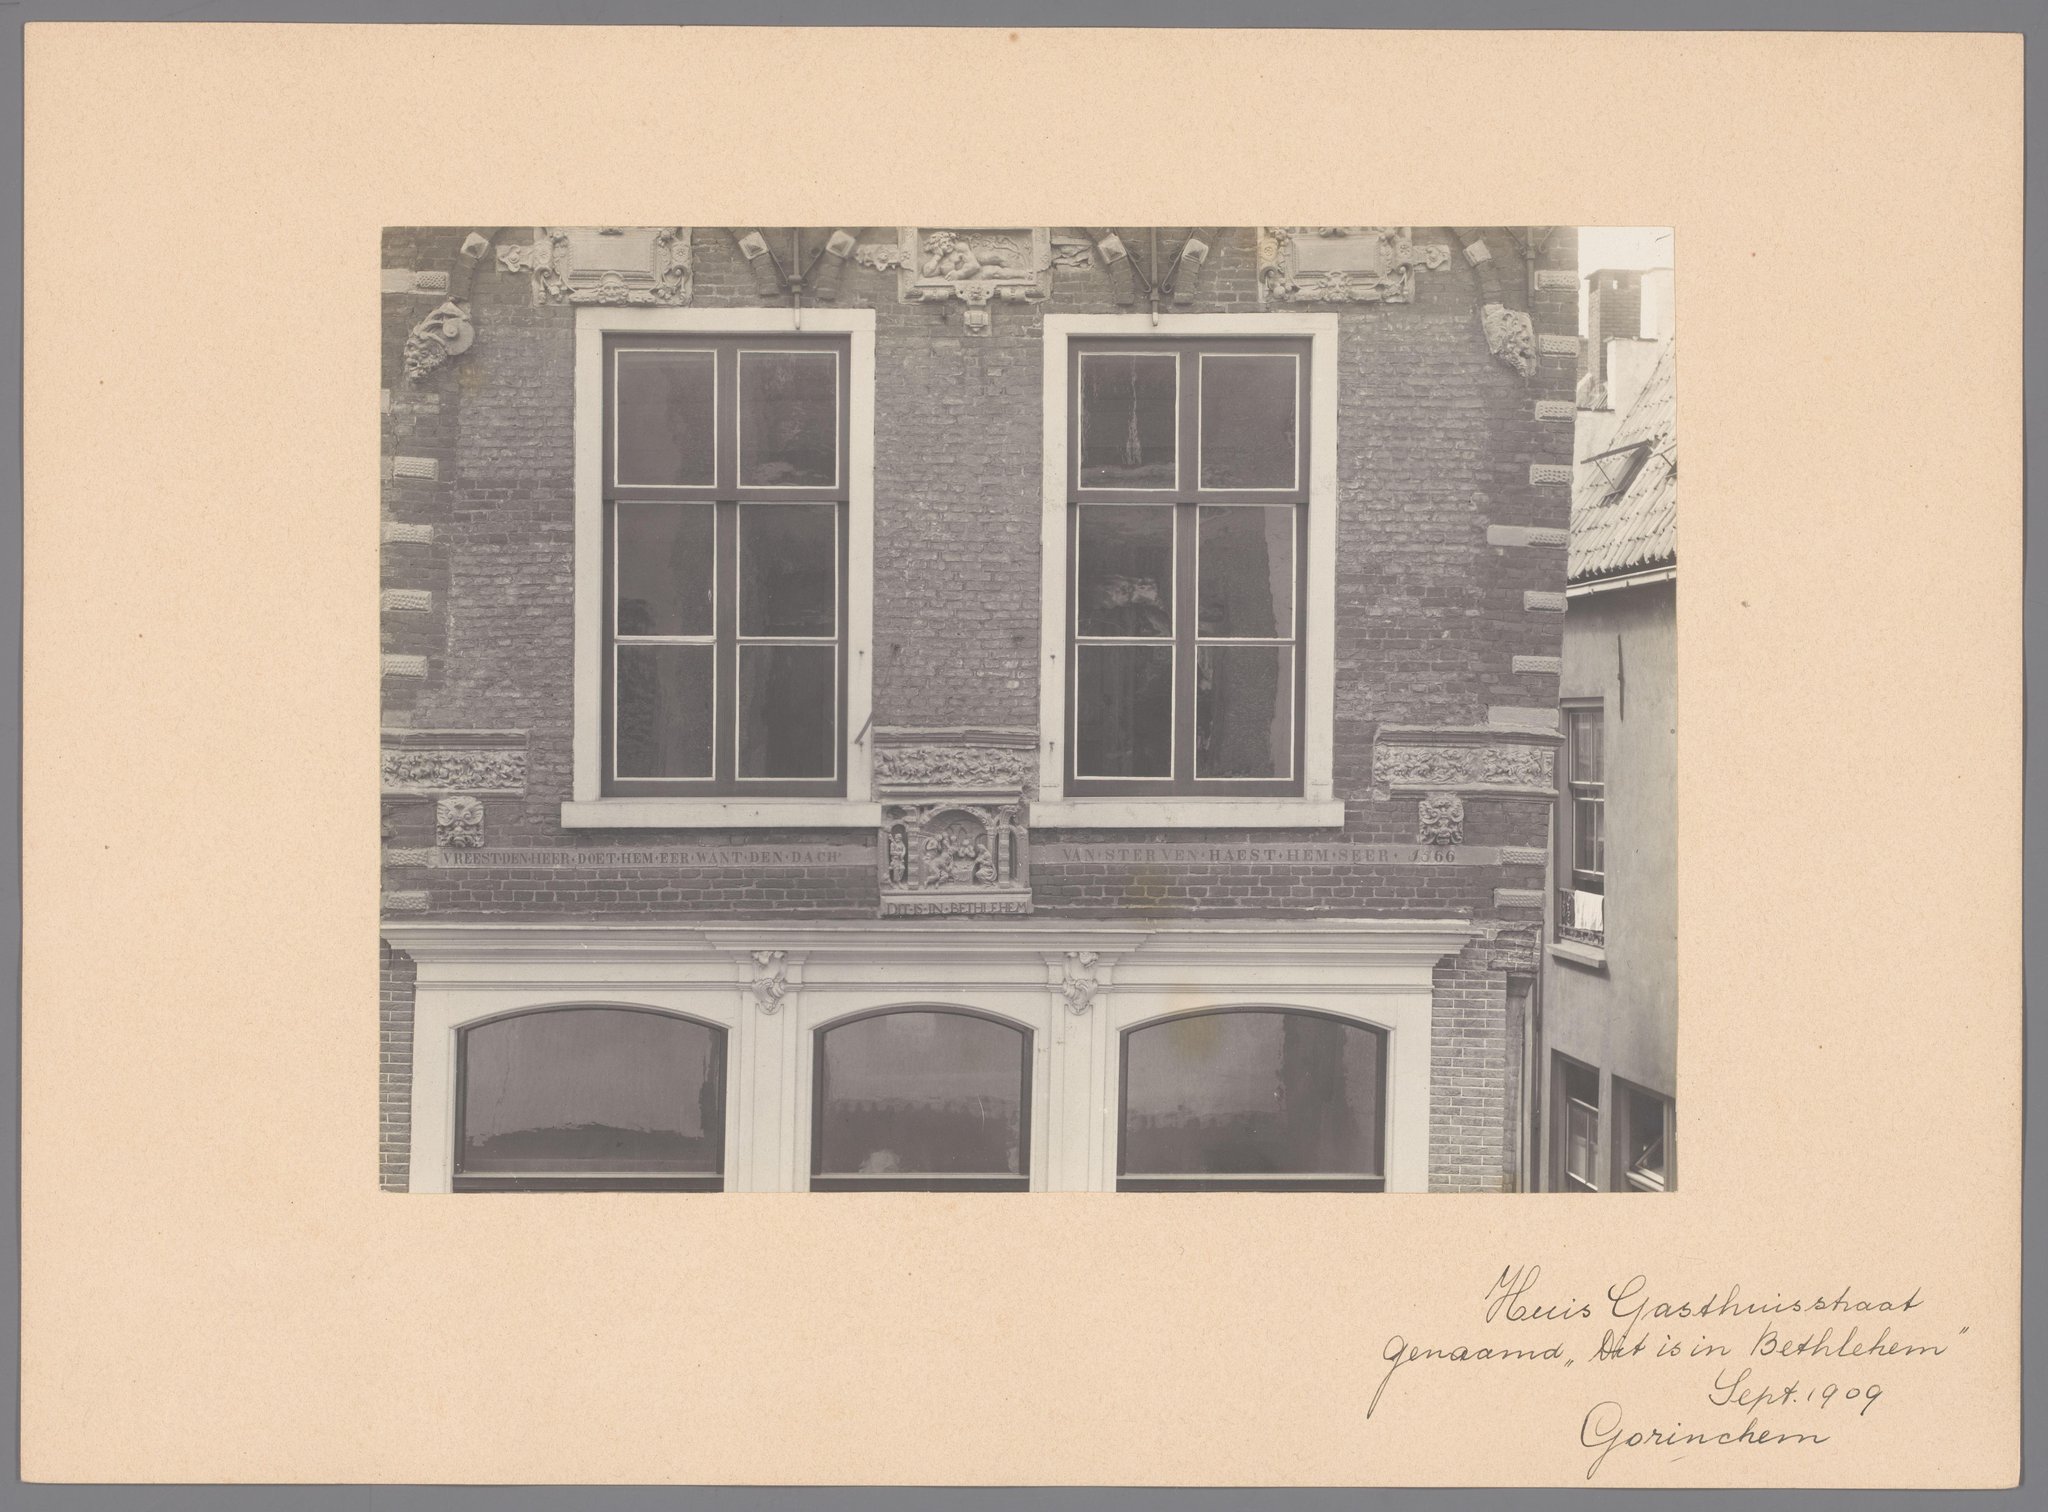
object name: photograph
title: Detail van het pand Dit is in Bethlehem te Gorinchem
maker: anoniem (monumentenzorg)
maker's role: fotograaf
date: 1909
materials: cardboard, photographic support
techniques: gelatin silver print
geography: gasthuisstraat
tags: urban housing, façade (of house or building)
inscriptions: annotation: ‘H. Schoenmaker/ 1470-’, annotation: ‘Huis Gasthuisstraat genaamd "Dit is in Bethlehem"/ Sept. 1909/ Gorinchem’